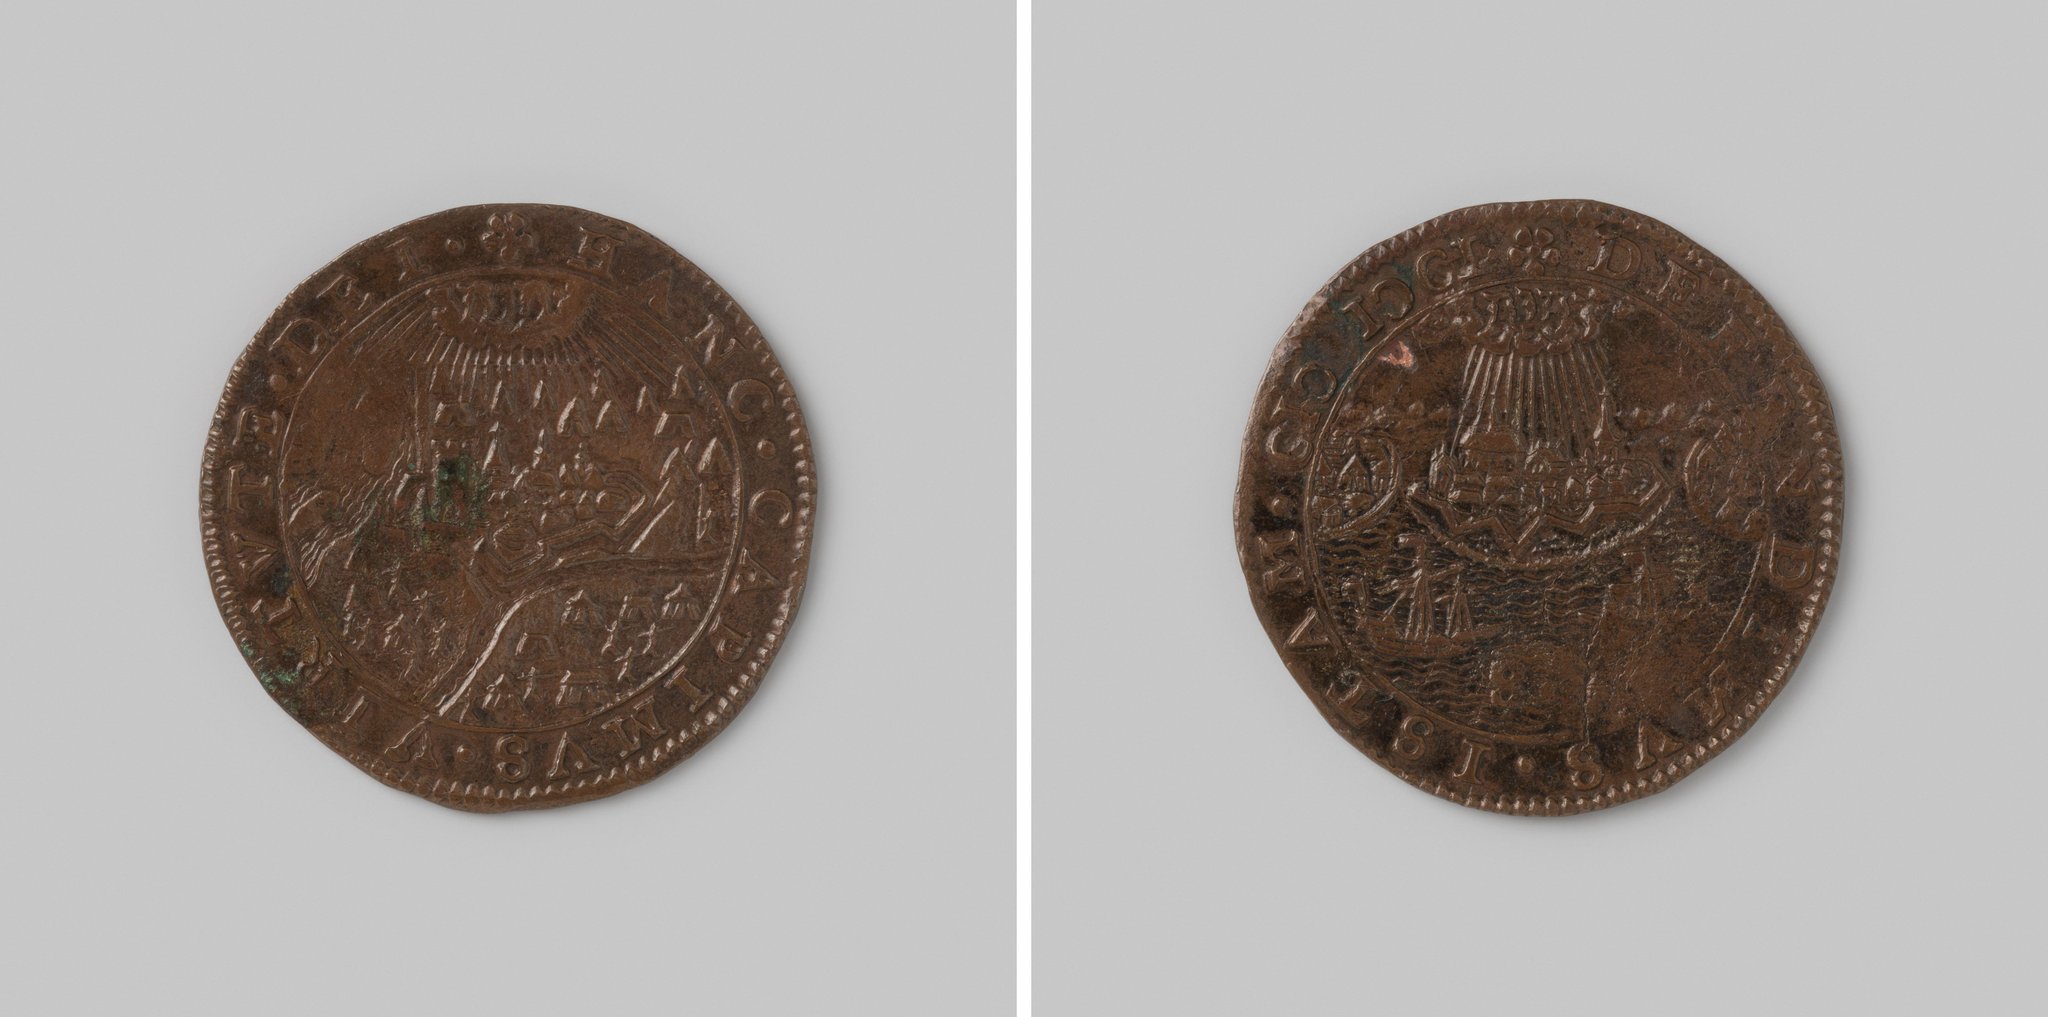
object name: history medal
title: Rekenpenning uit Dordrecht op het beleg van Ostende door de Spaanse troepen 1601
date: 1601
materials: copper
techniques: striking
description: Koperen penning, op de voorzijde de door legerkampen omringde stad Ostende in vogelvlucht, met omschrift, op de keerzijde de belegerde stad door hemels licht beschenen, met omschrift.